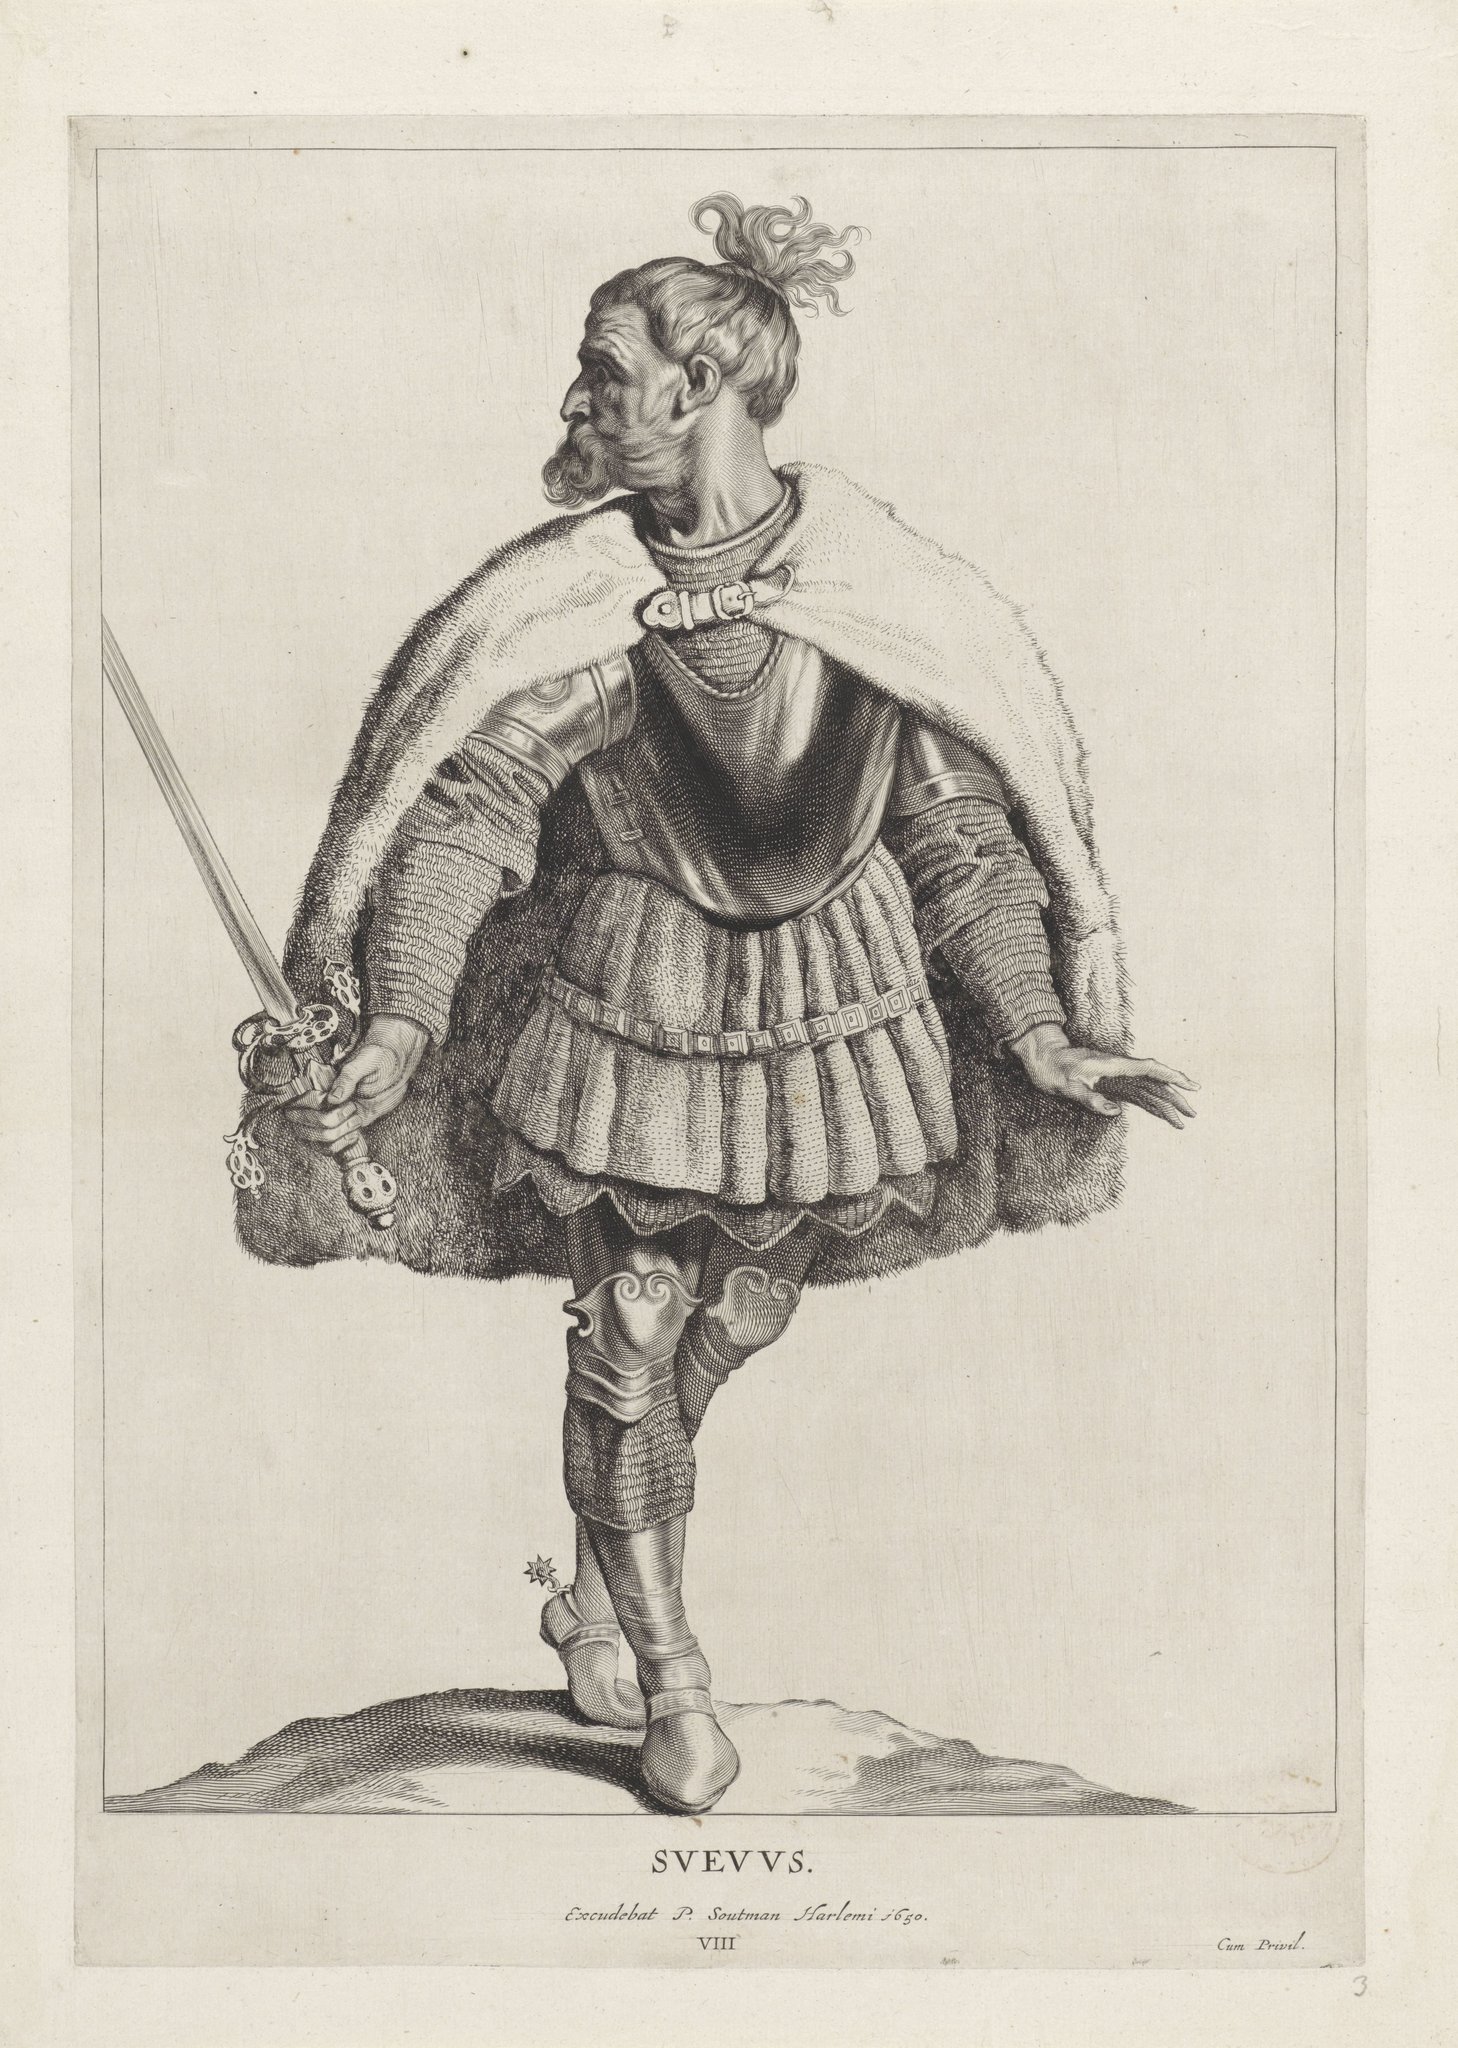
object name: costume print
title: Peplus sive Gothorum, Wandalorum, Svevorum, Herulorum, Gepidarum, Marcomannorum et quadorum veterum Imagines ex antiquis monumentis et museo Marci Zuerii Boxhornii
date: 1650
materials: paper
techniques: engraving, etching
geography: haarlem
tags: armour, hacking and thrusting weapons: sword, extinct, 'historical' peoples (with name)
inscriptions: collector's mark: Lugt 240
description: Krijger van het Germaanse volk der Sueben of Sueven, staande ten voeten uit, gewapend met zwaard in de rechterhand.